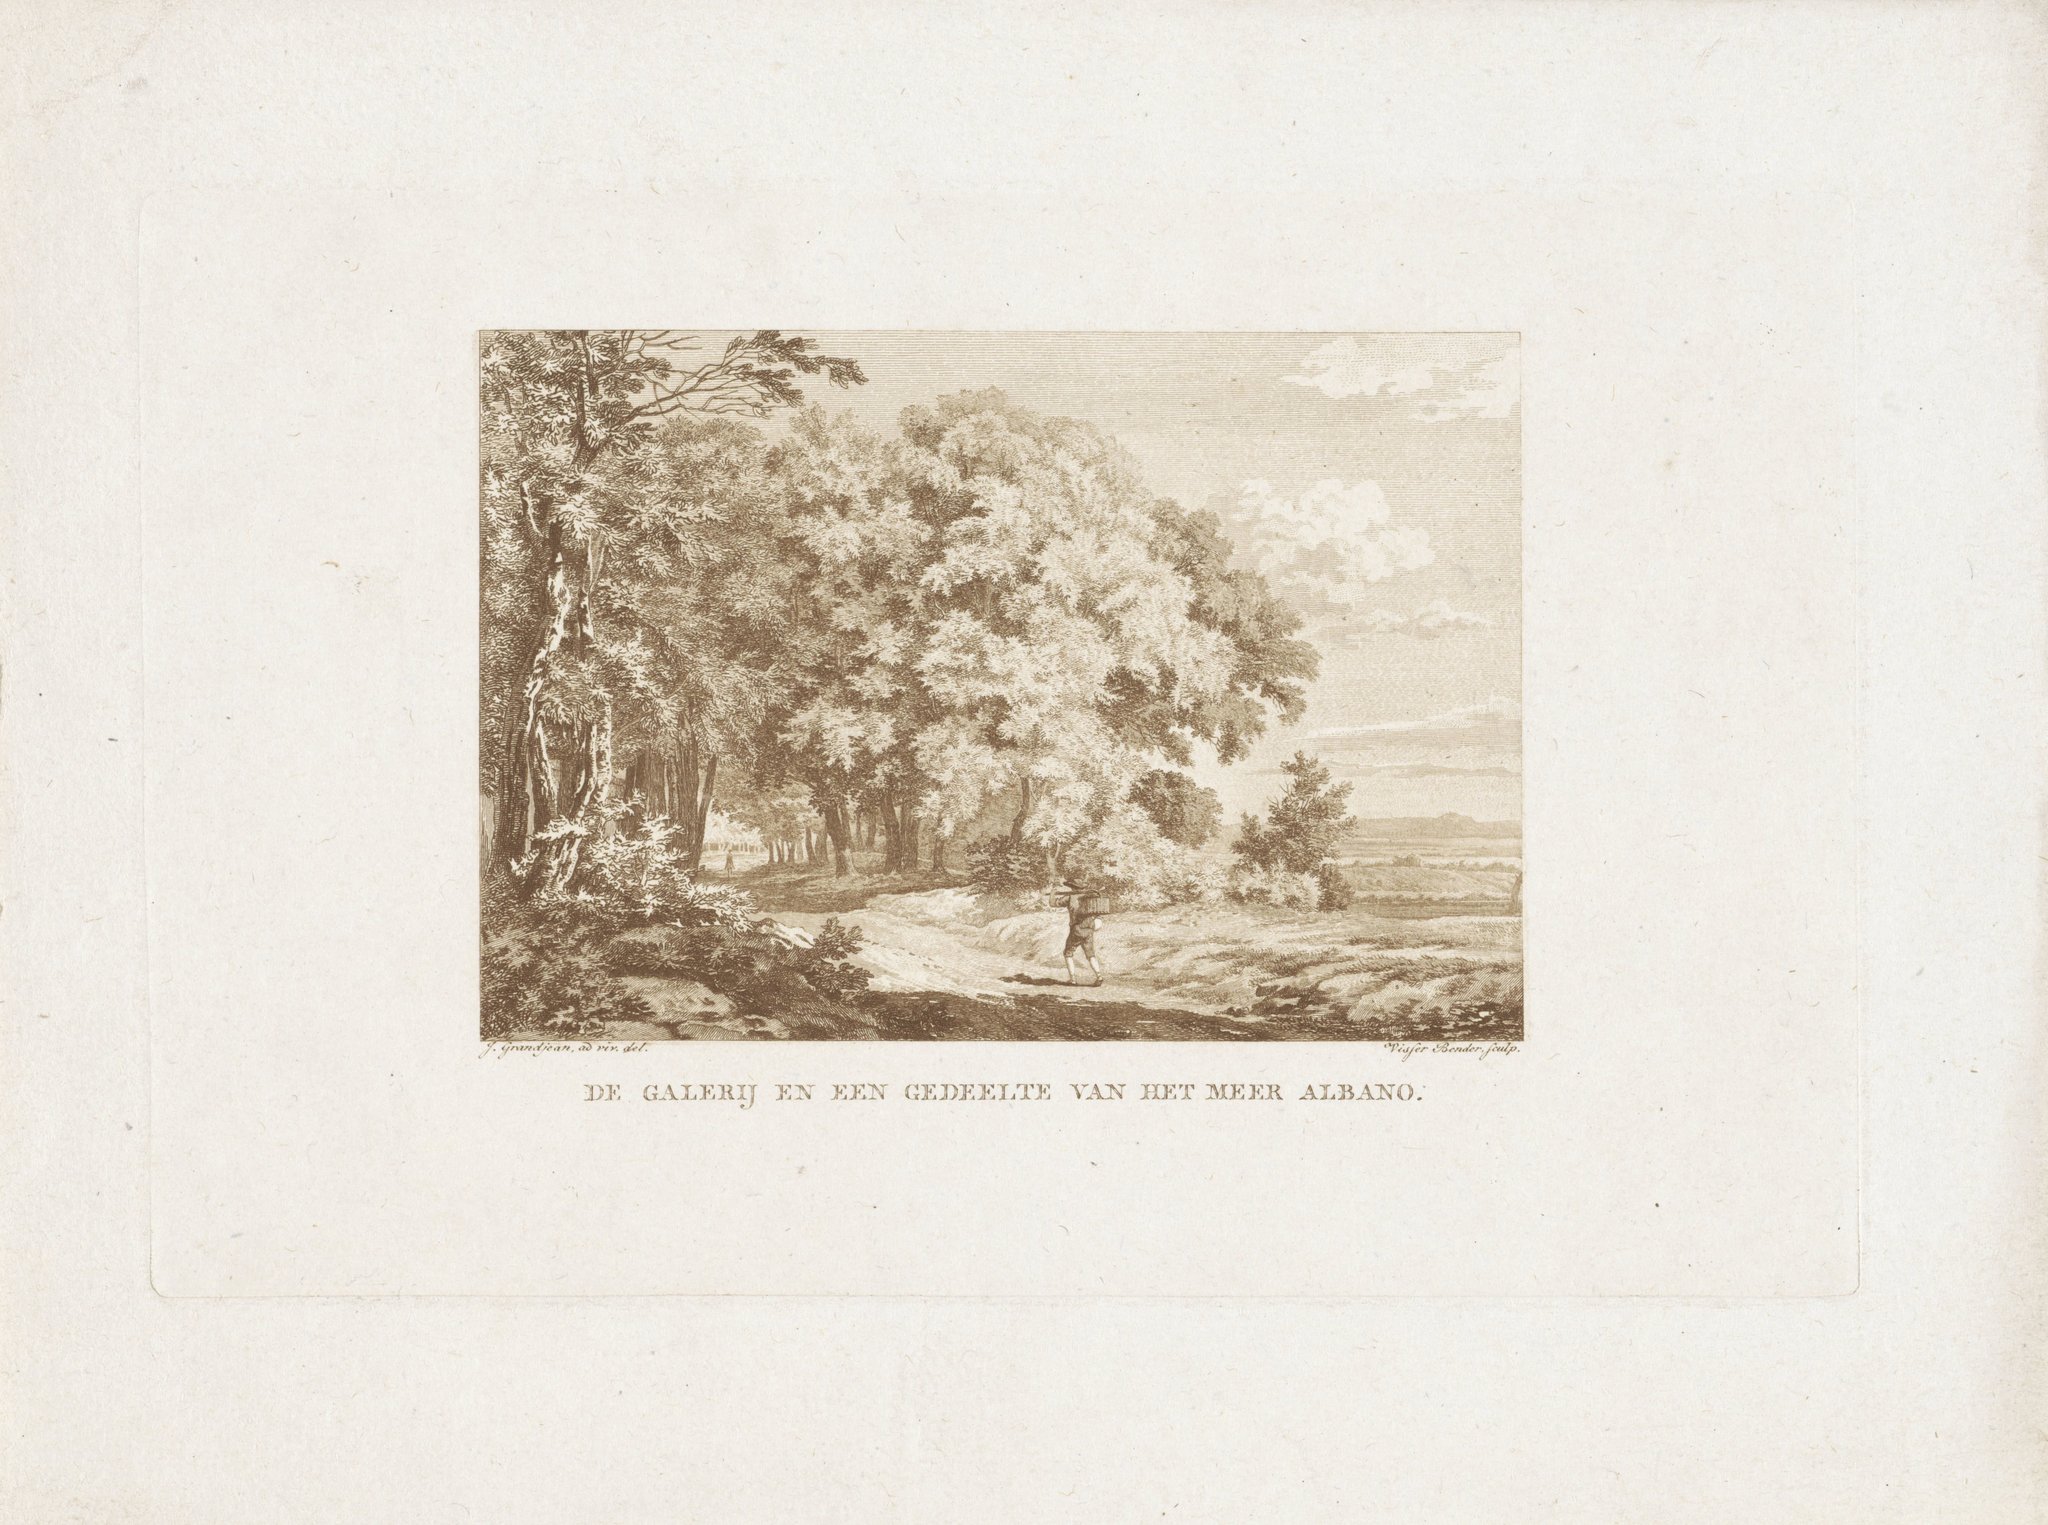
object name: print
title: De Galerij en een Gedeelte van het Meer Albano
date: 1795-1813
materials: paper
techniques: etching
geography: haarlem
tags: forest path or lane, 'en route', traveller under way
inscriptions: collector's mark: Lugt 2228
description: Reiziger op een bospad langs het Lago di Albano in Iatlië.